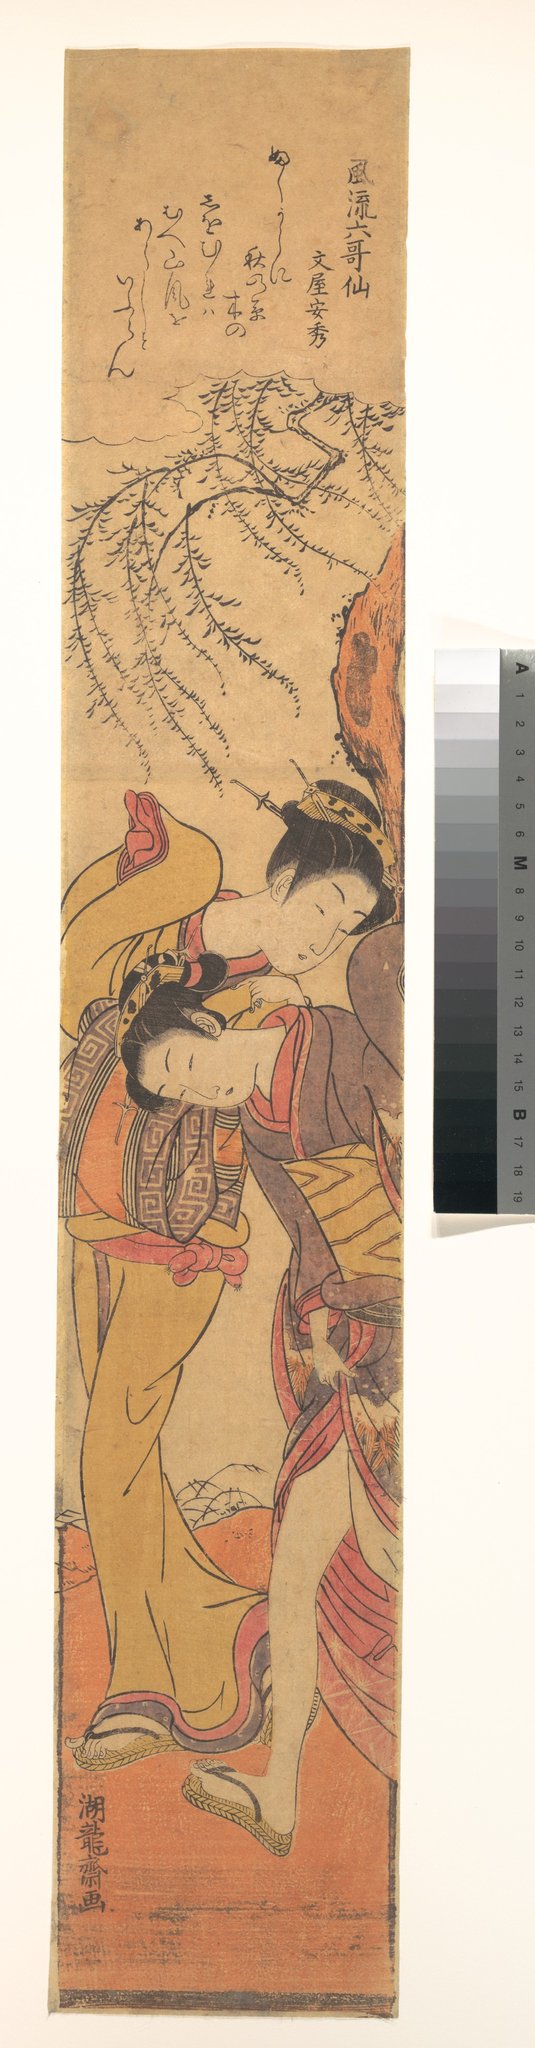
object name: print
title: A Breezy Day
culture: japanese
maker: isoda koryūsai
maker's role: artist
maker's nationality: japanese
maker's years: 1735-1790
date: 1770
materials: ink, paper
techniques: woodblock print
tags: women